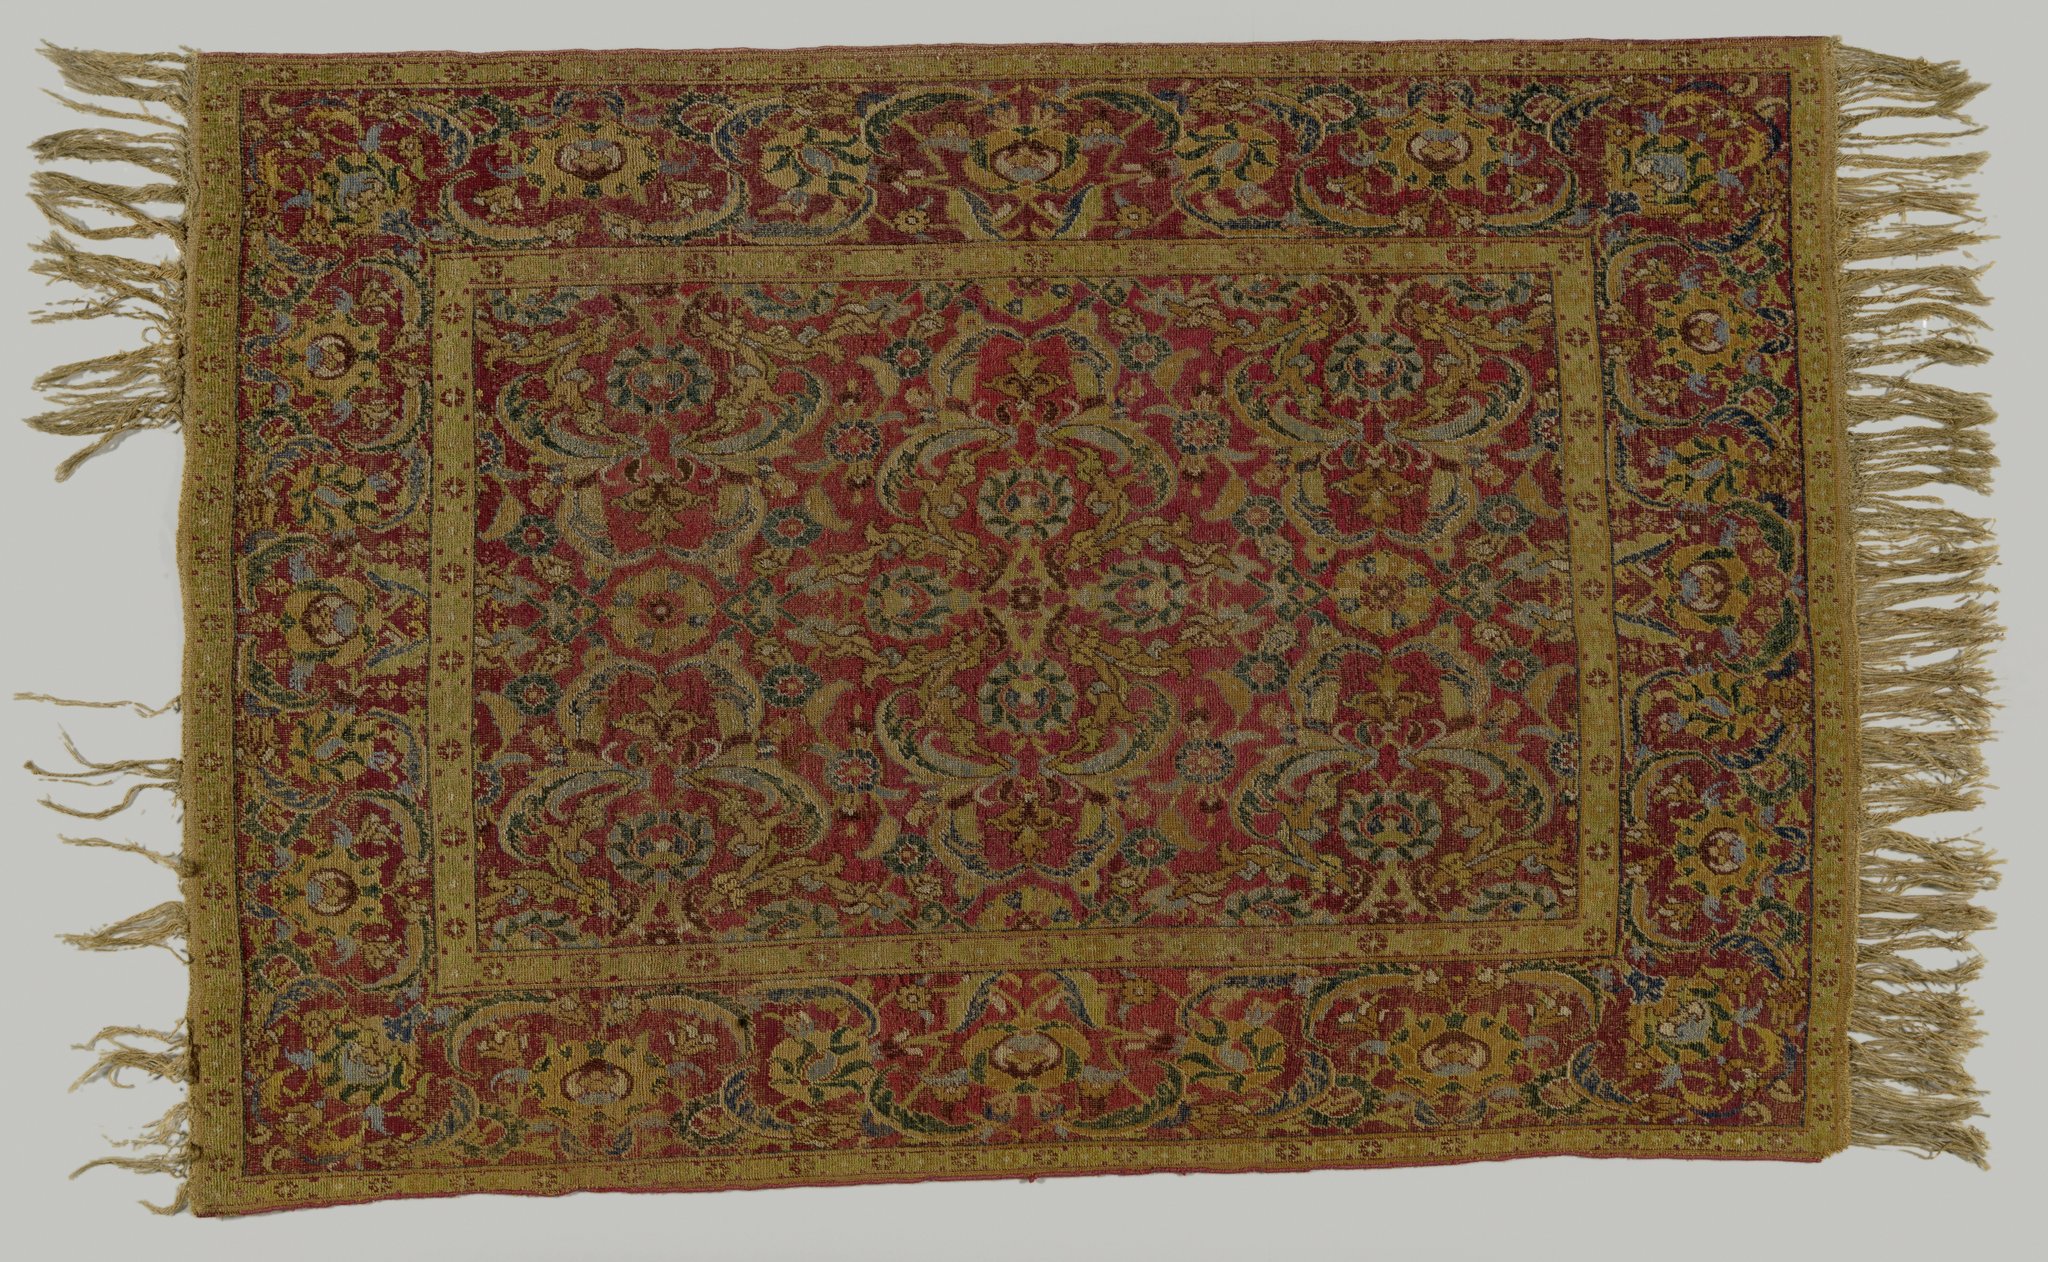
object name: oriental rug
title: Bloemenkleed, z.g. "OTTOMAAN"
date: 1600-1650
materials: wool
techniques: senneh knot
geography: turkey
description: Bloemenkleed, z.g. "OTTOMAAN" in ceriserode fond en rand.